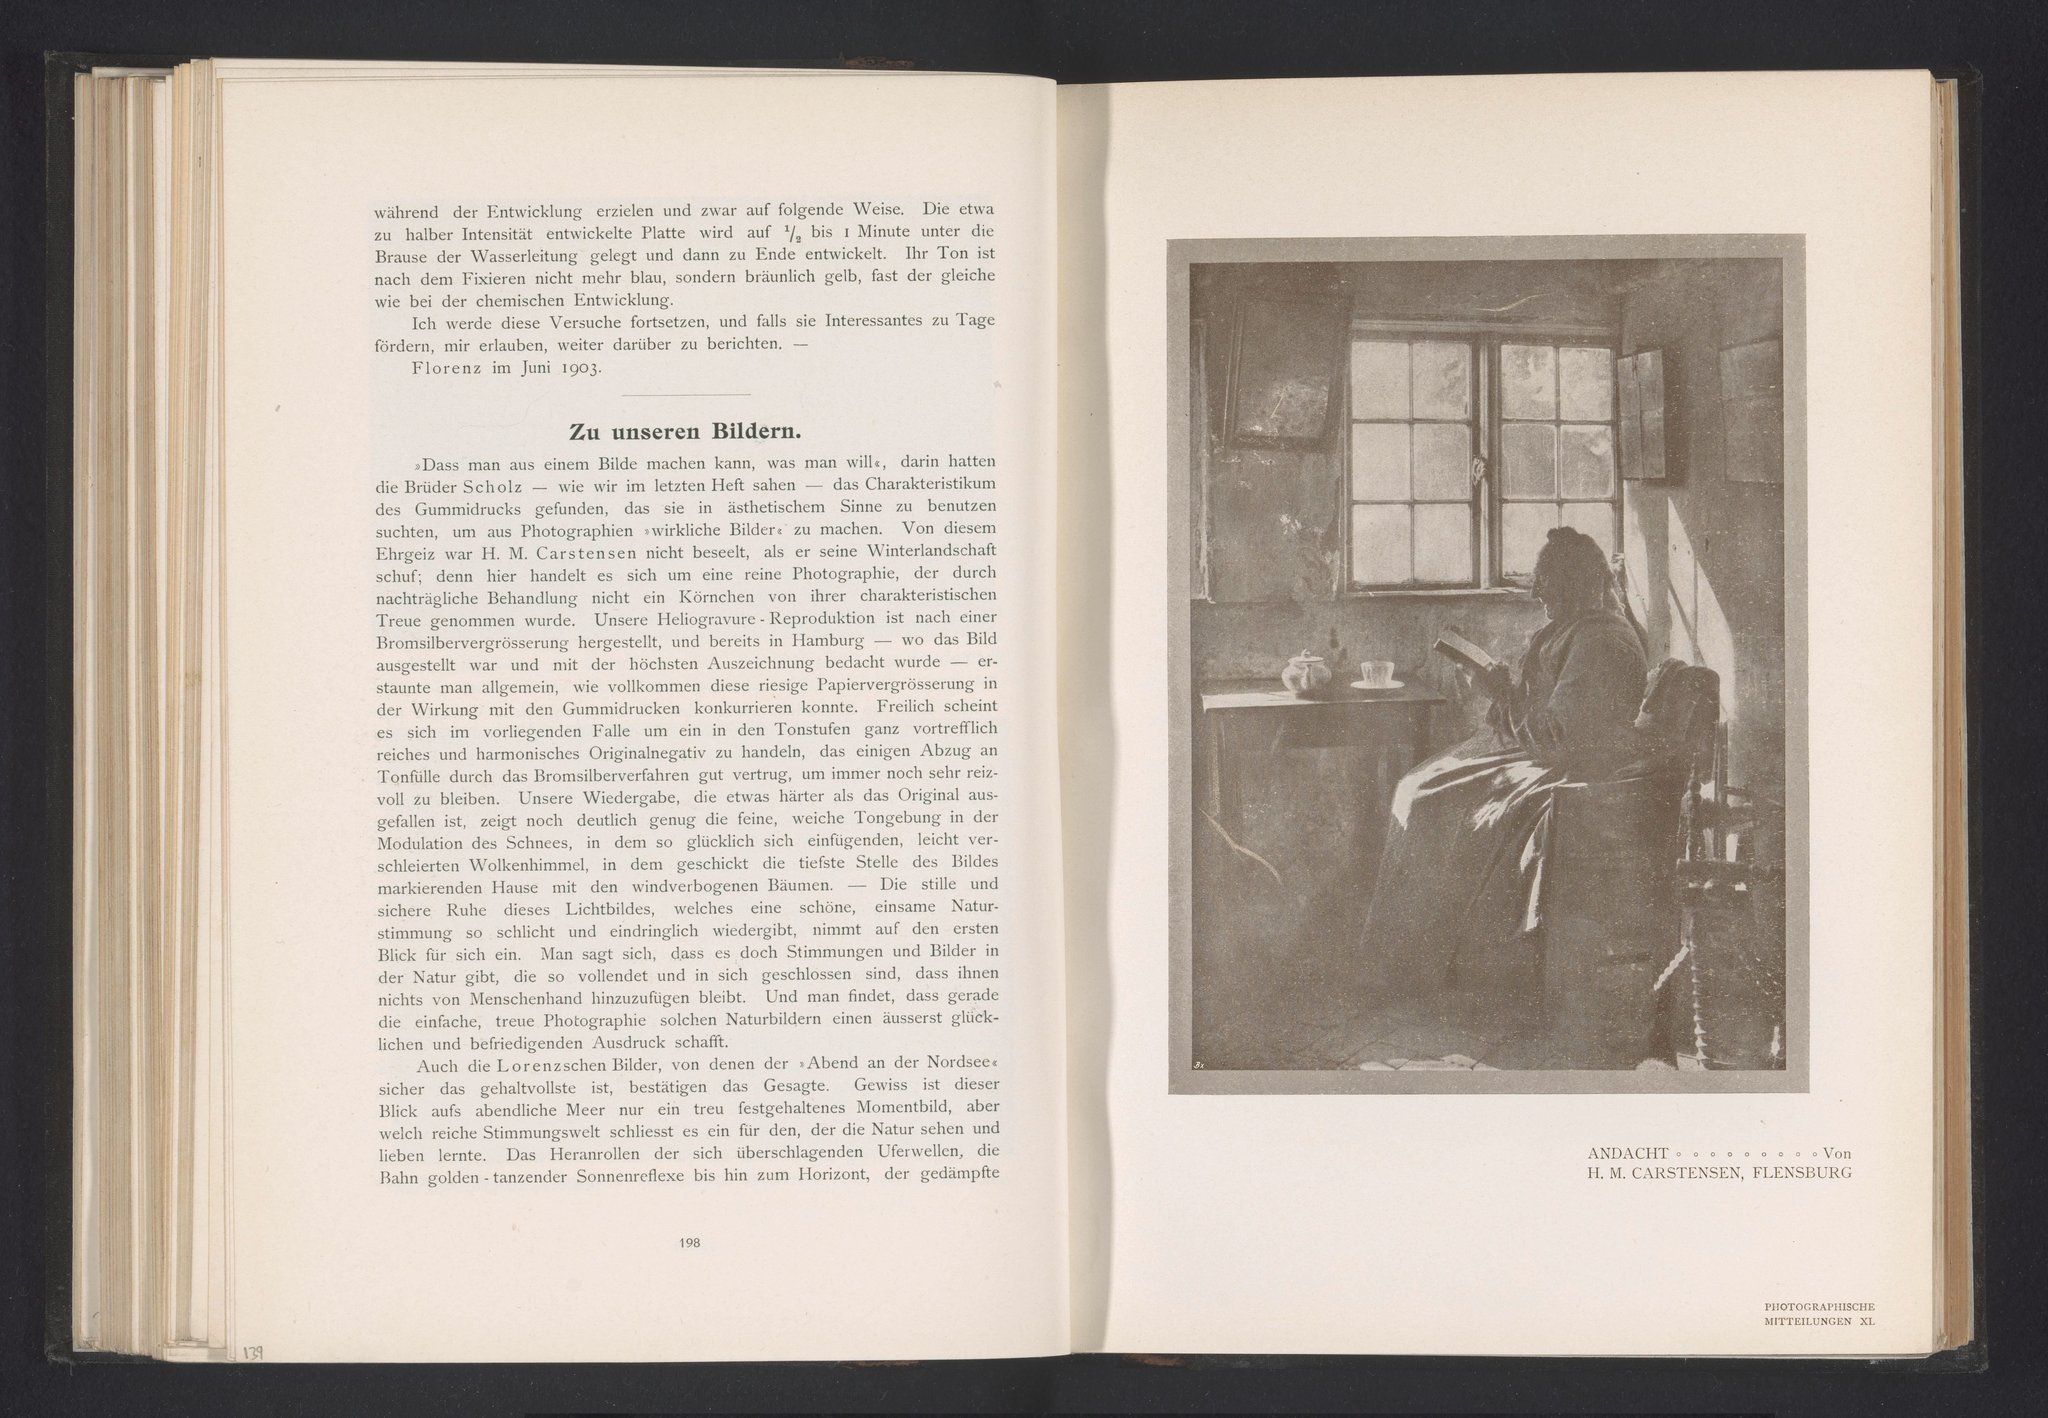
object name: photomechanical print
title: Andacht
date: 1898-1903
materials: paper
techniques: autotype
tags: historical persons - bb - woman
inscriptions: inscription: ‘Photographische Mitteilungen XL’, monogram: ‘BX’